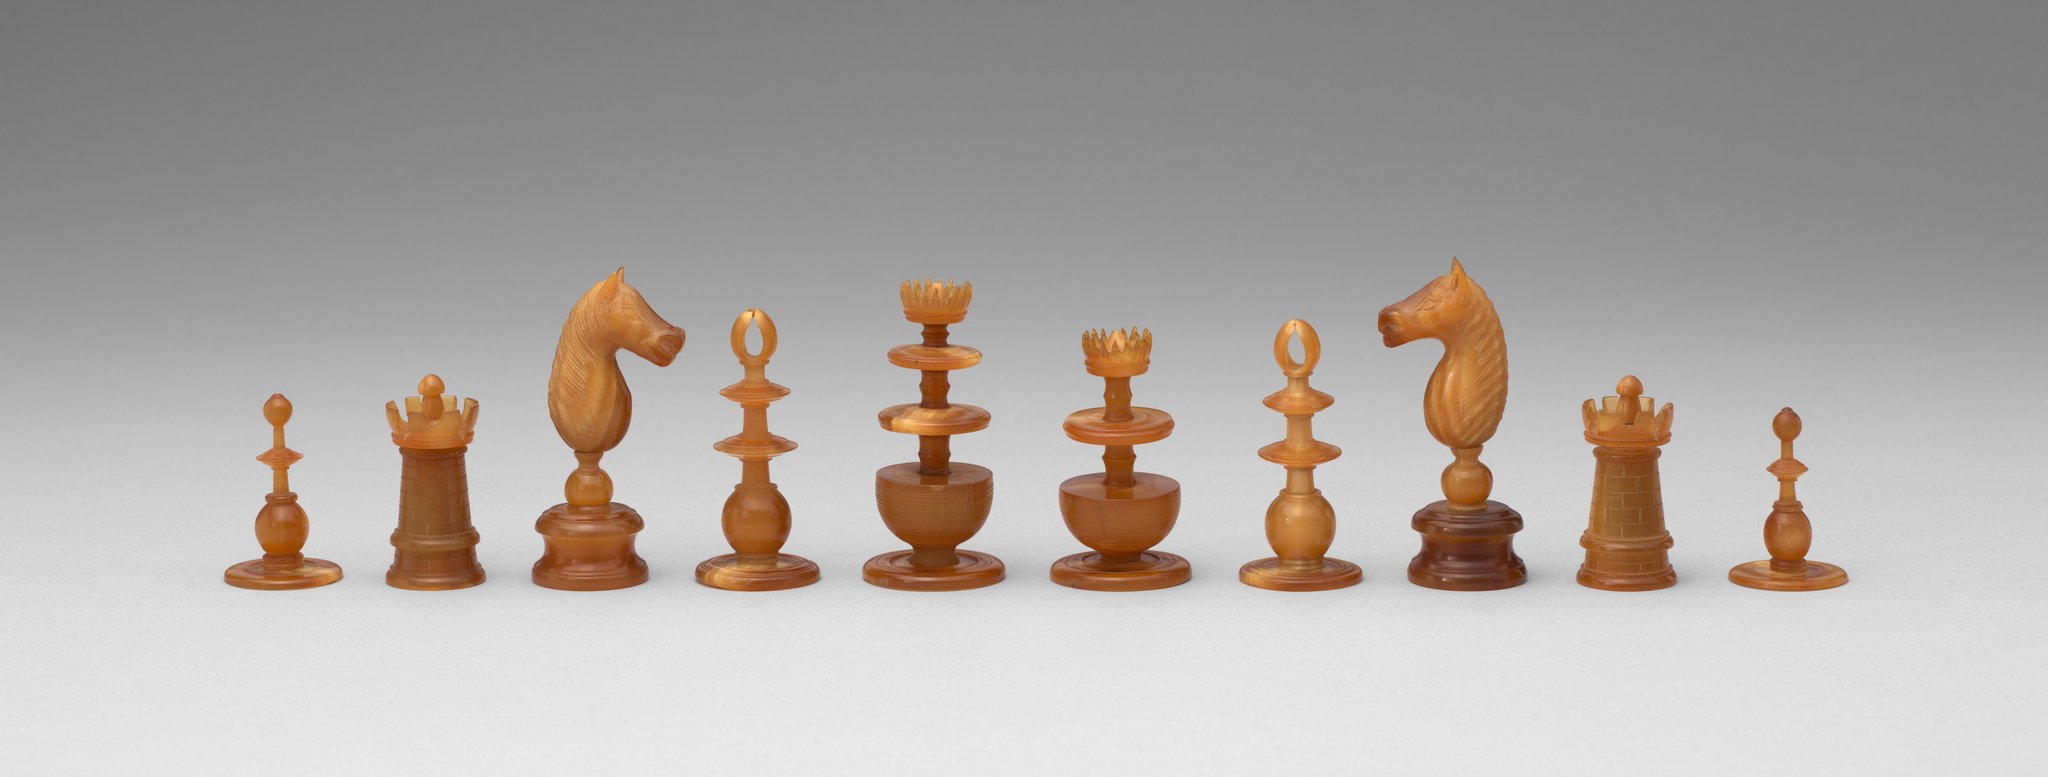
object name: chessman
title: Chessmen (32)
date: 1701-1800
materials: ivory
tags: chess,games